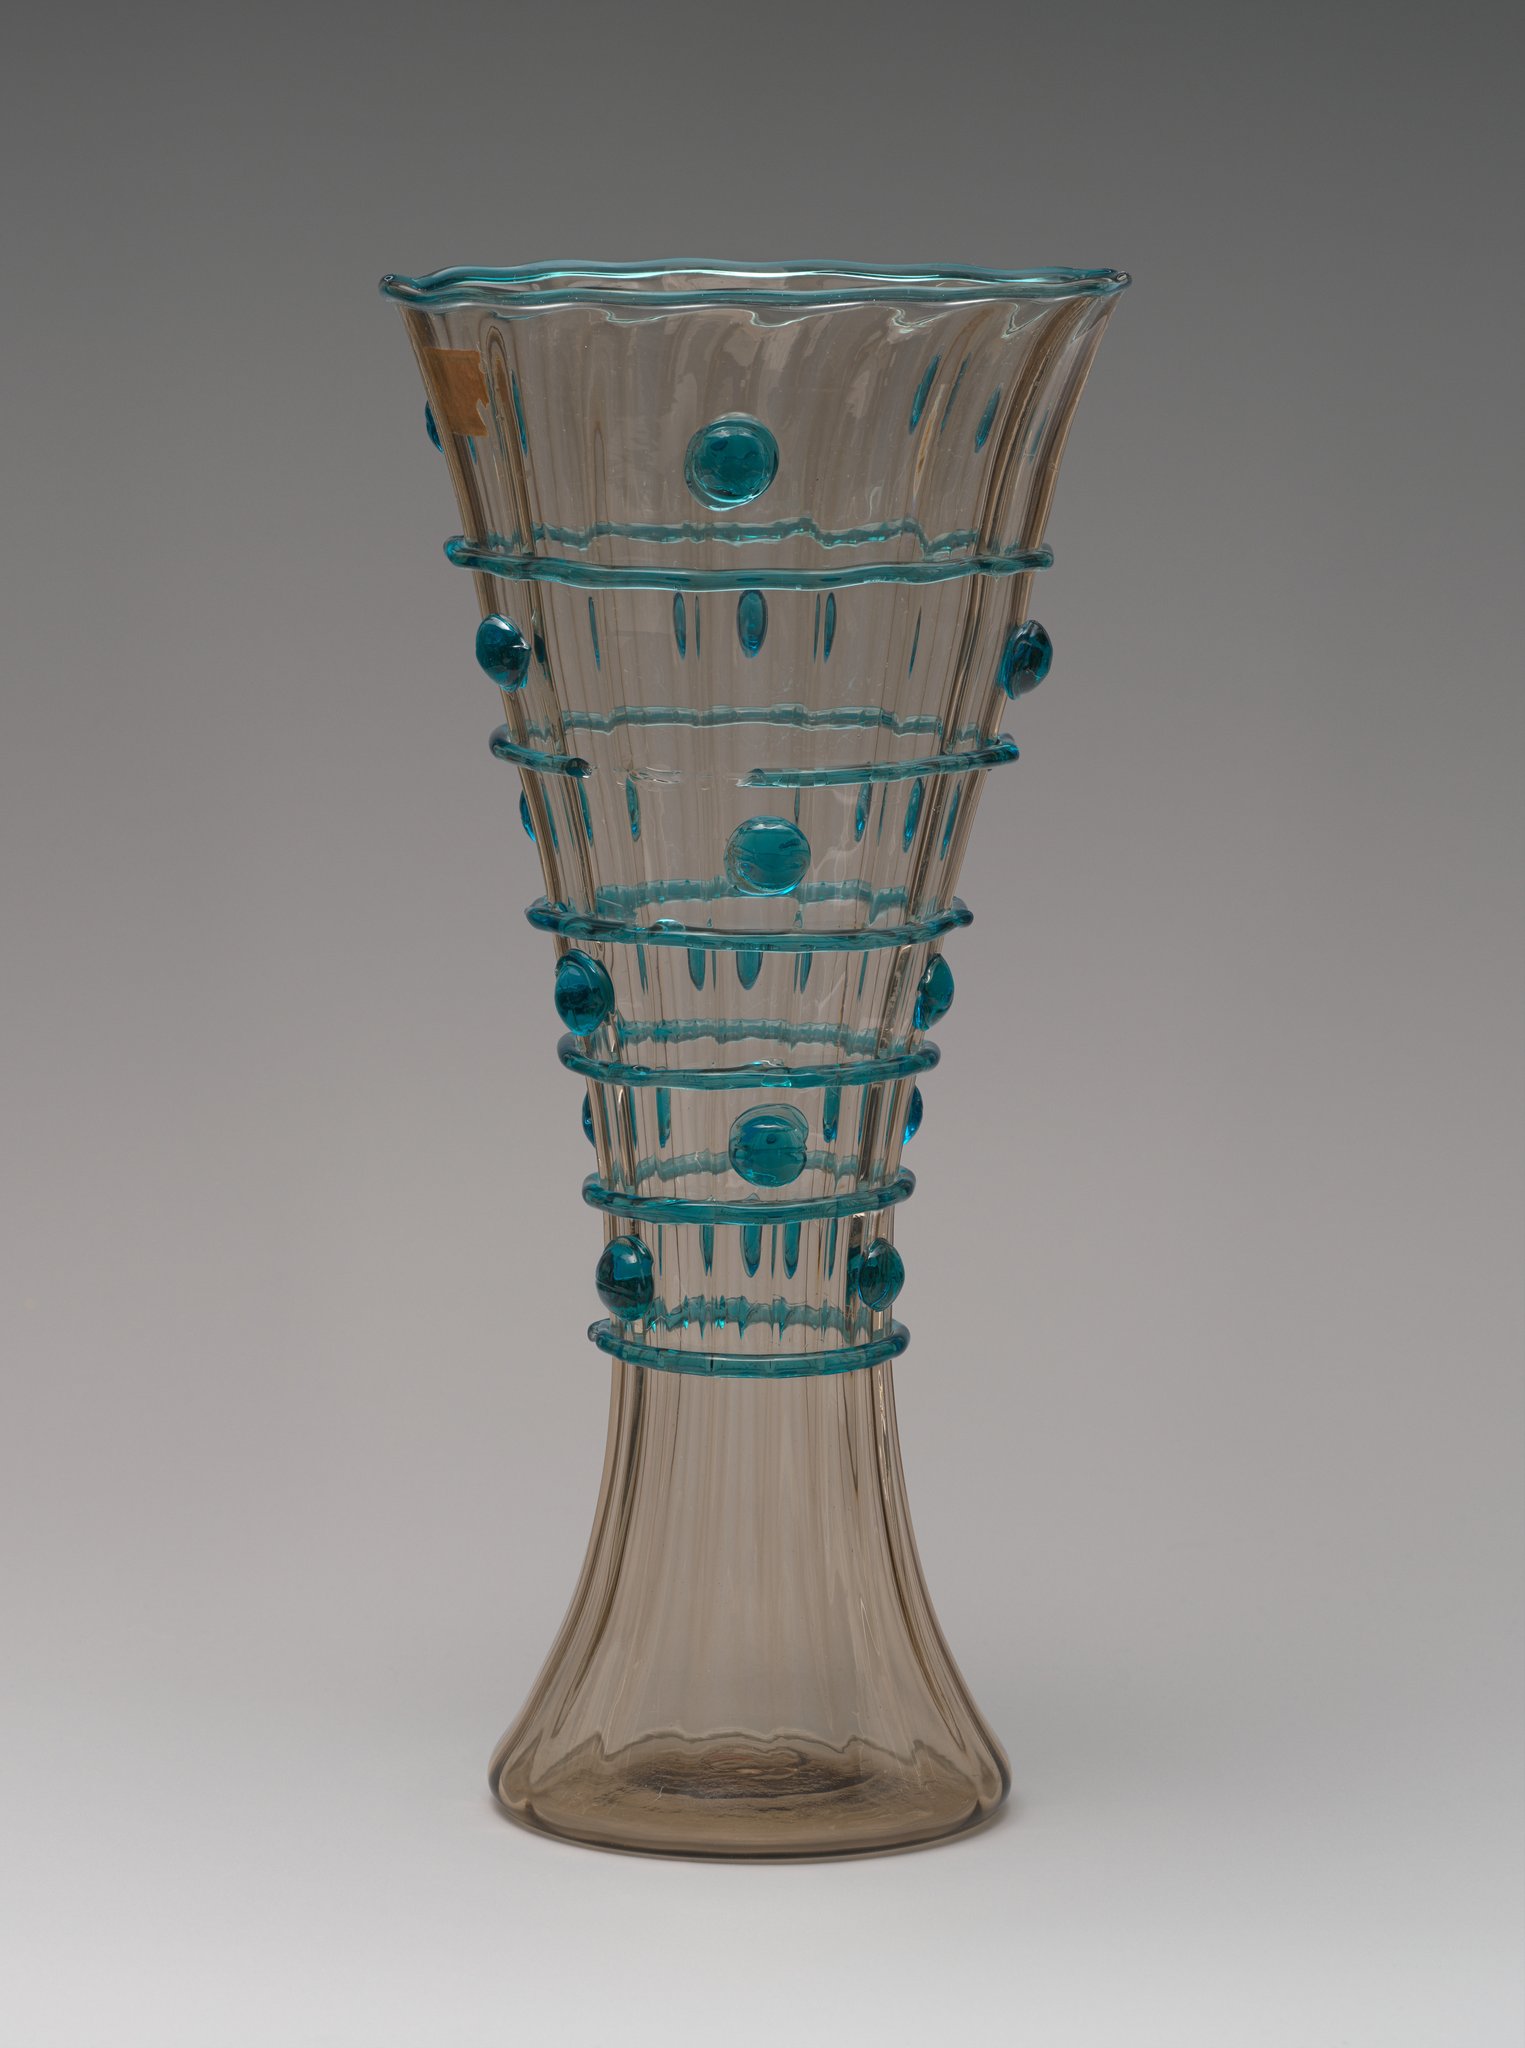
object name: vase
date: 1801-1900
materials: glass